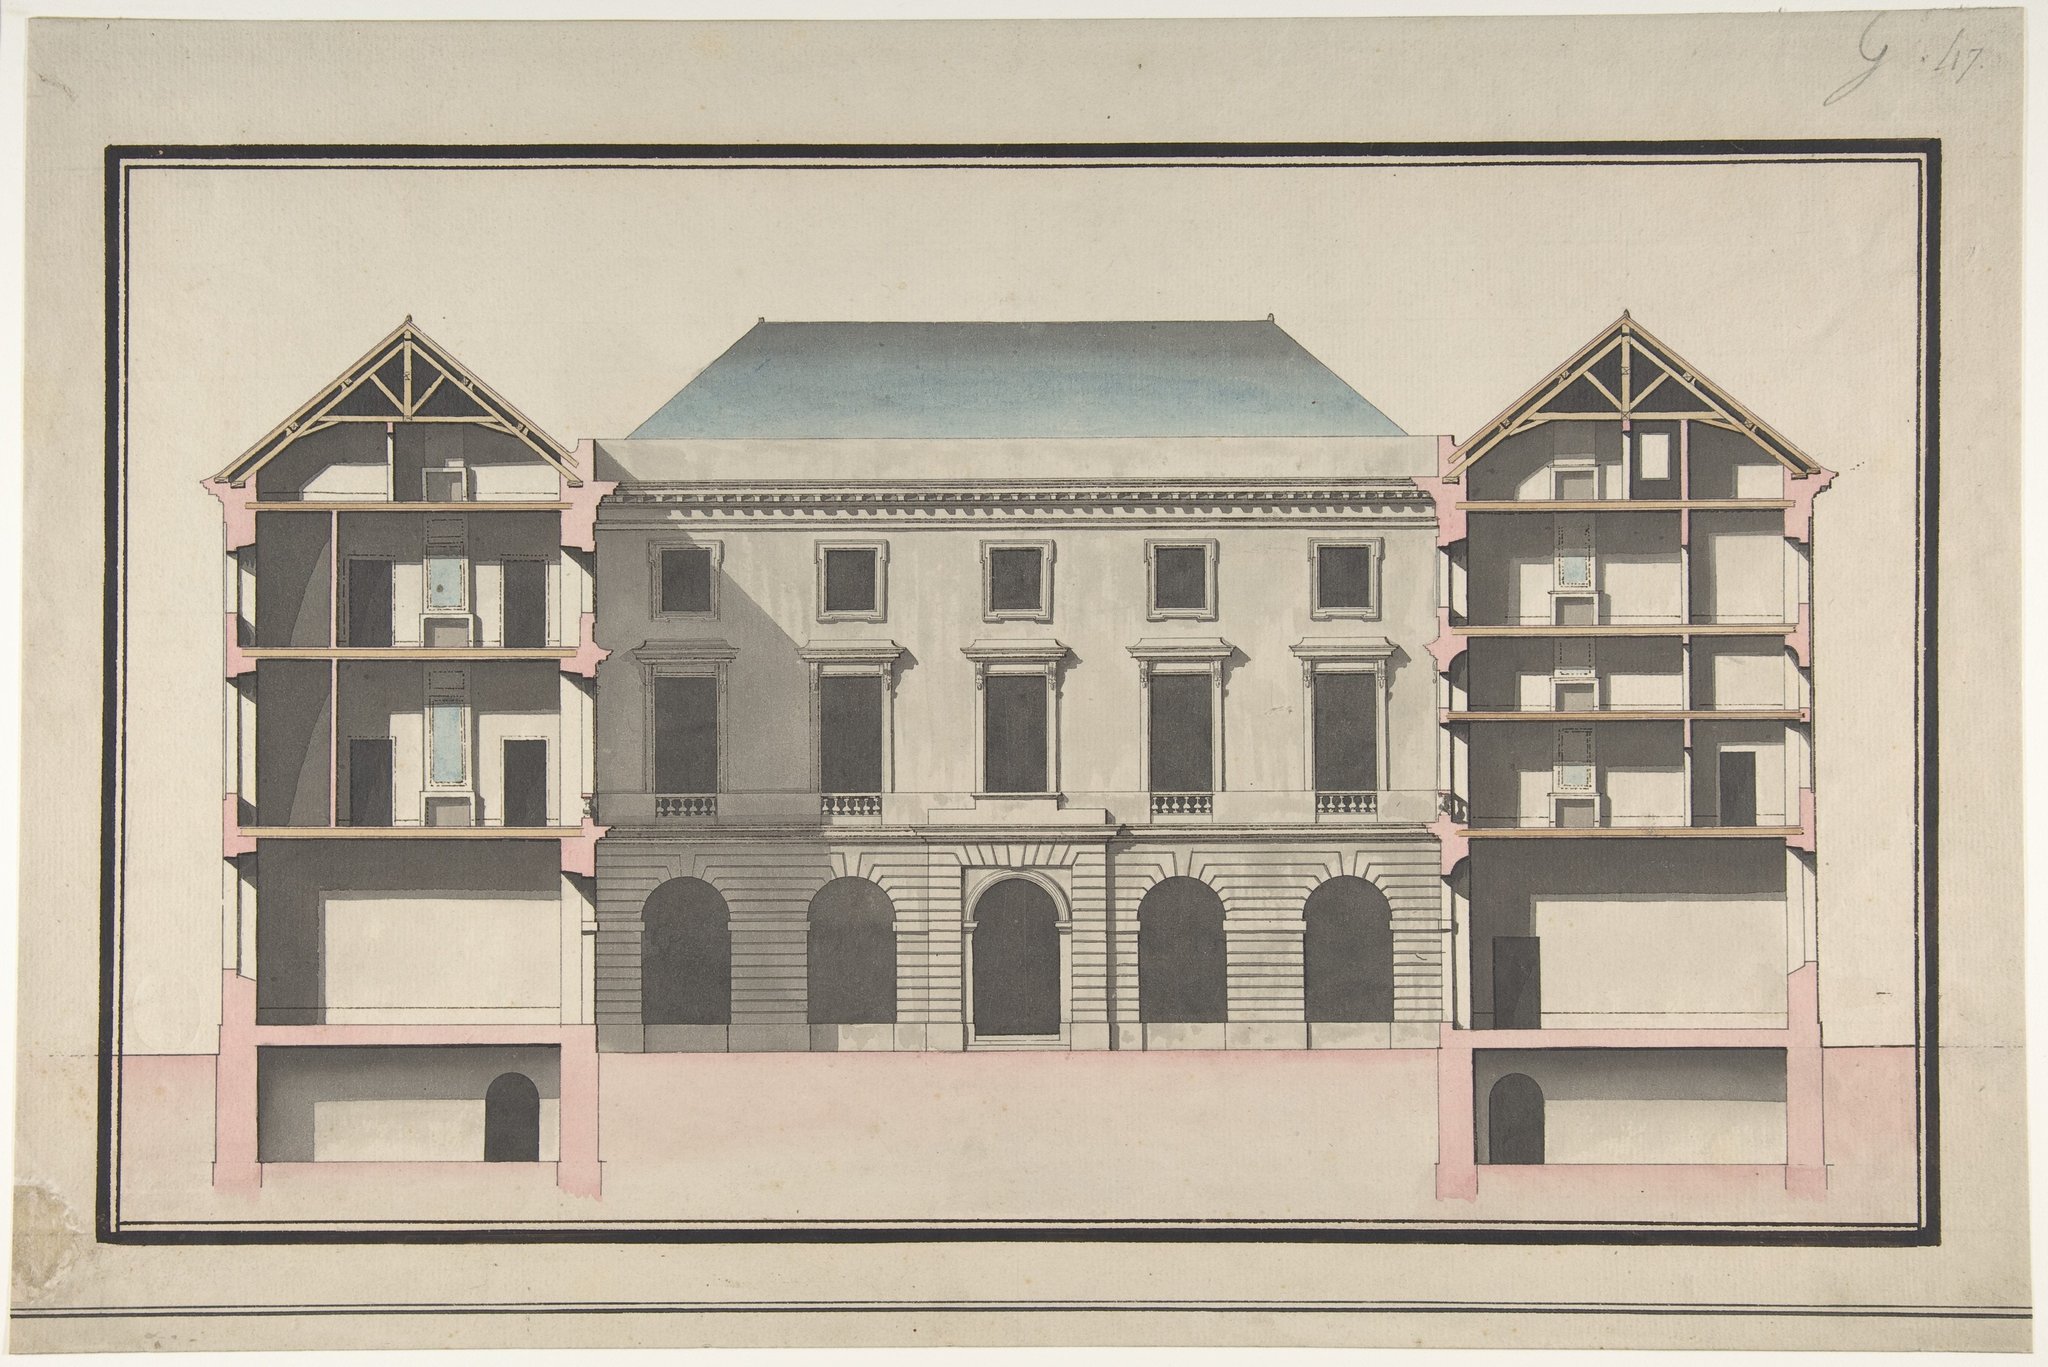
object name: drawing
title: Design for the Collège de France, Paris: Elevation of Court Front with Traverse Sections Through Side Court Wings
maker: jean françois chalgrin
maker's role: artist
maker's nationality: french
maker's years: 1739-1811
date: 1772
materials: ink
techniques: pen, wash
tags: architecture,buildings